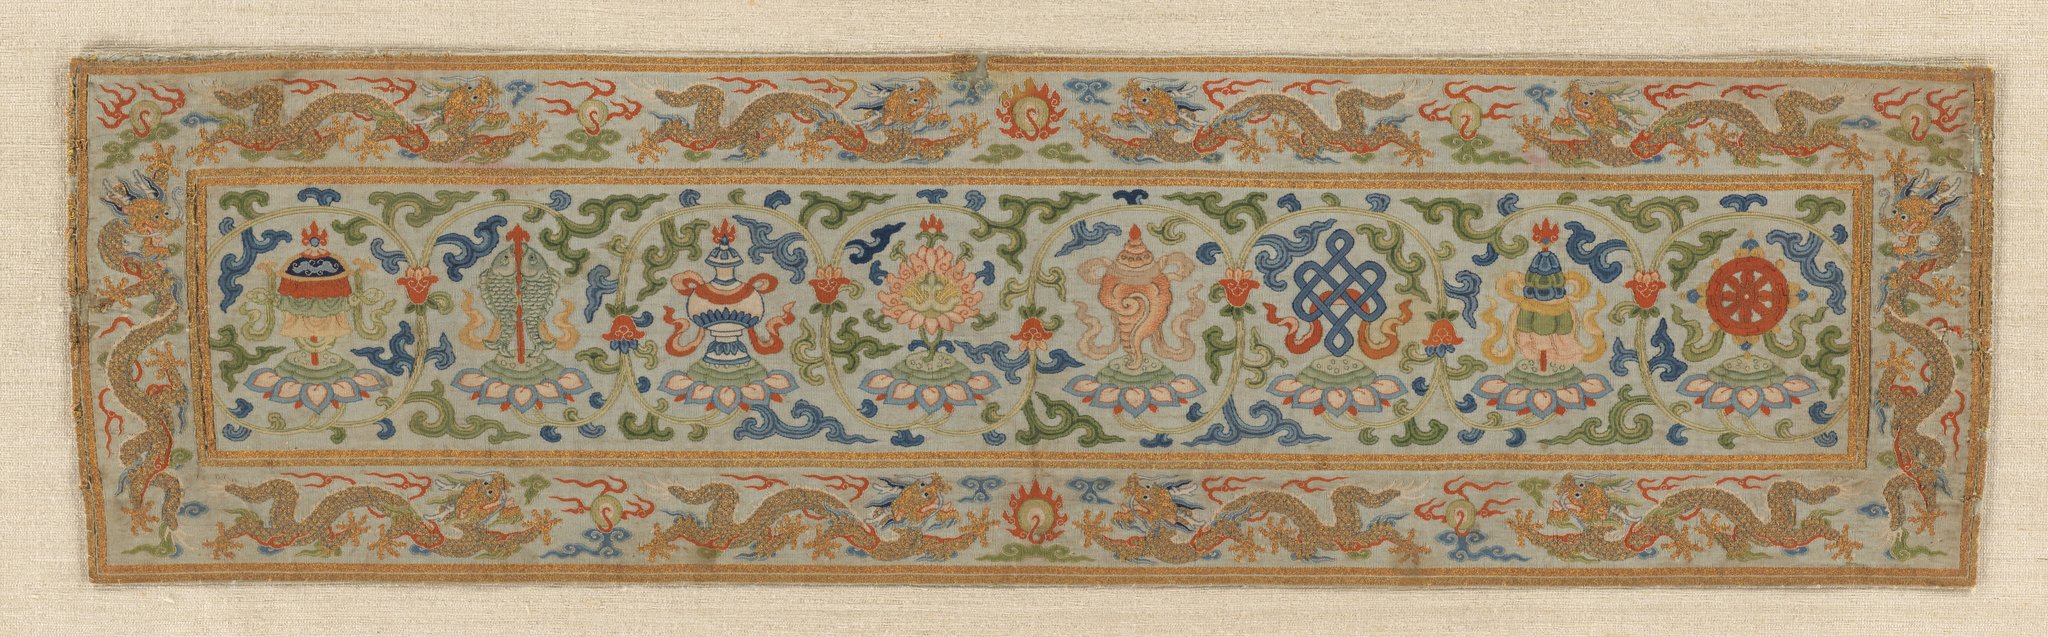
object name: sutra cover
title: Sutra Cover with Eight Buddhist Treasures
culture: chinese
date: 1701-1800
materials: metal thread, silk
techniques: tapestry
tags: dragons,fish,lotuses,shells,buddhism